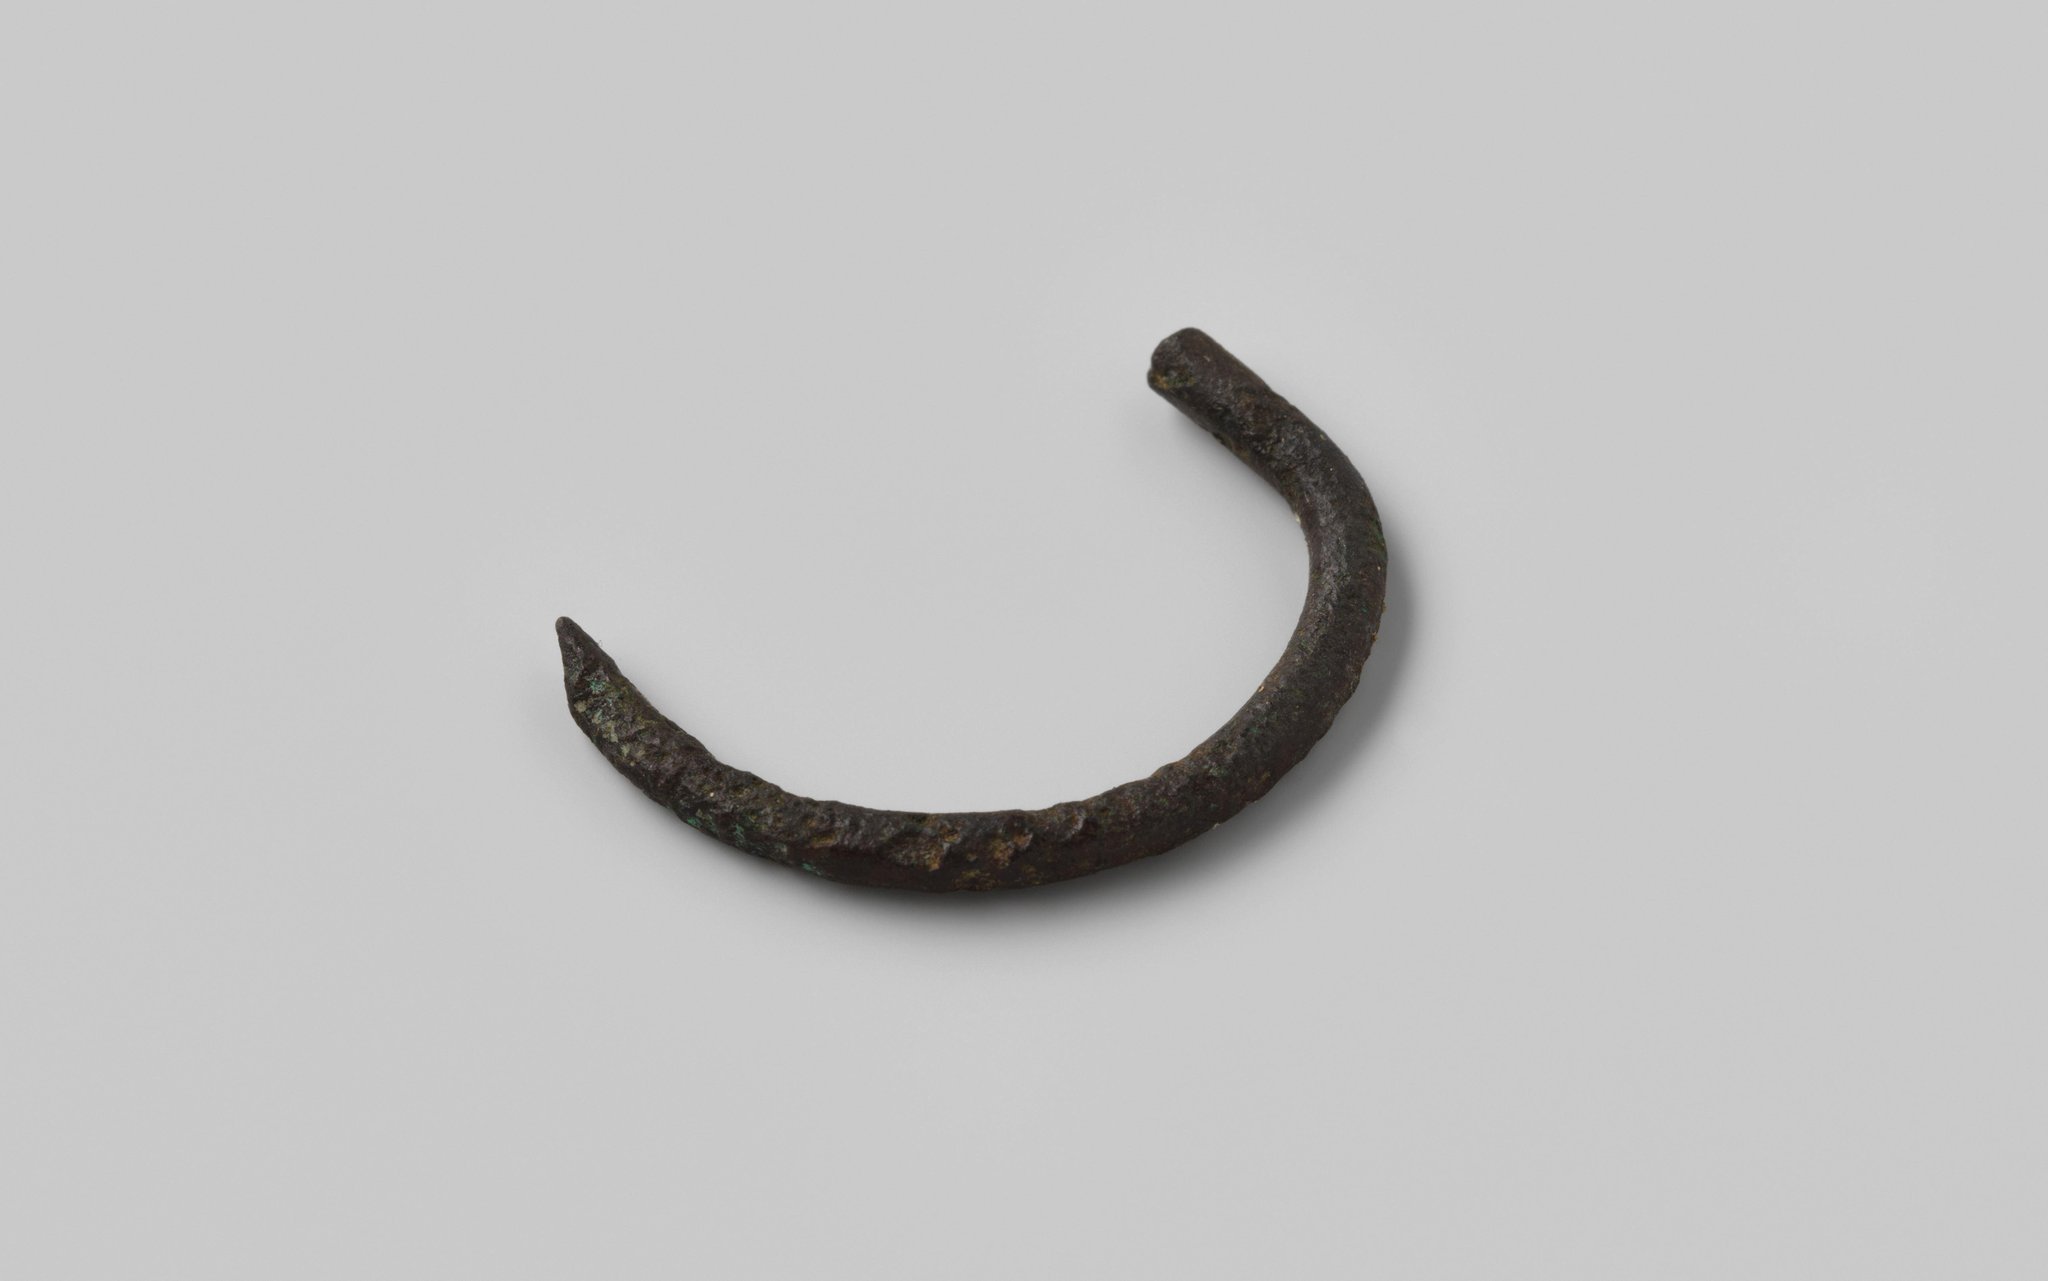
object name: ring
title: Fragment ringvormig object uit het wrak van de Oost-Indiëvaarder Hollandia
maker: Anonymous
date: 1700-1743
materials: copper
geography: netherlands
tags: verenigde oostindische compagnie, hollandia (schip), annet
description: Varied parts or fragments, rings or ring-shaped fragments; fragm, eroded, id. 80H946.